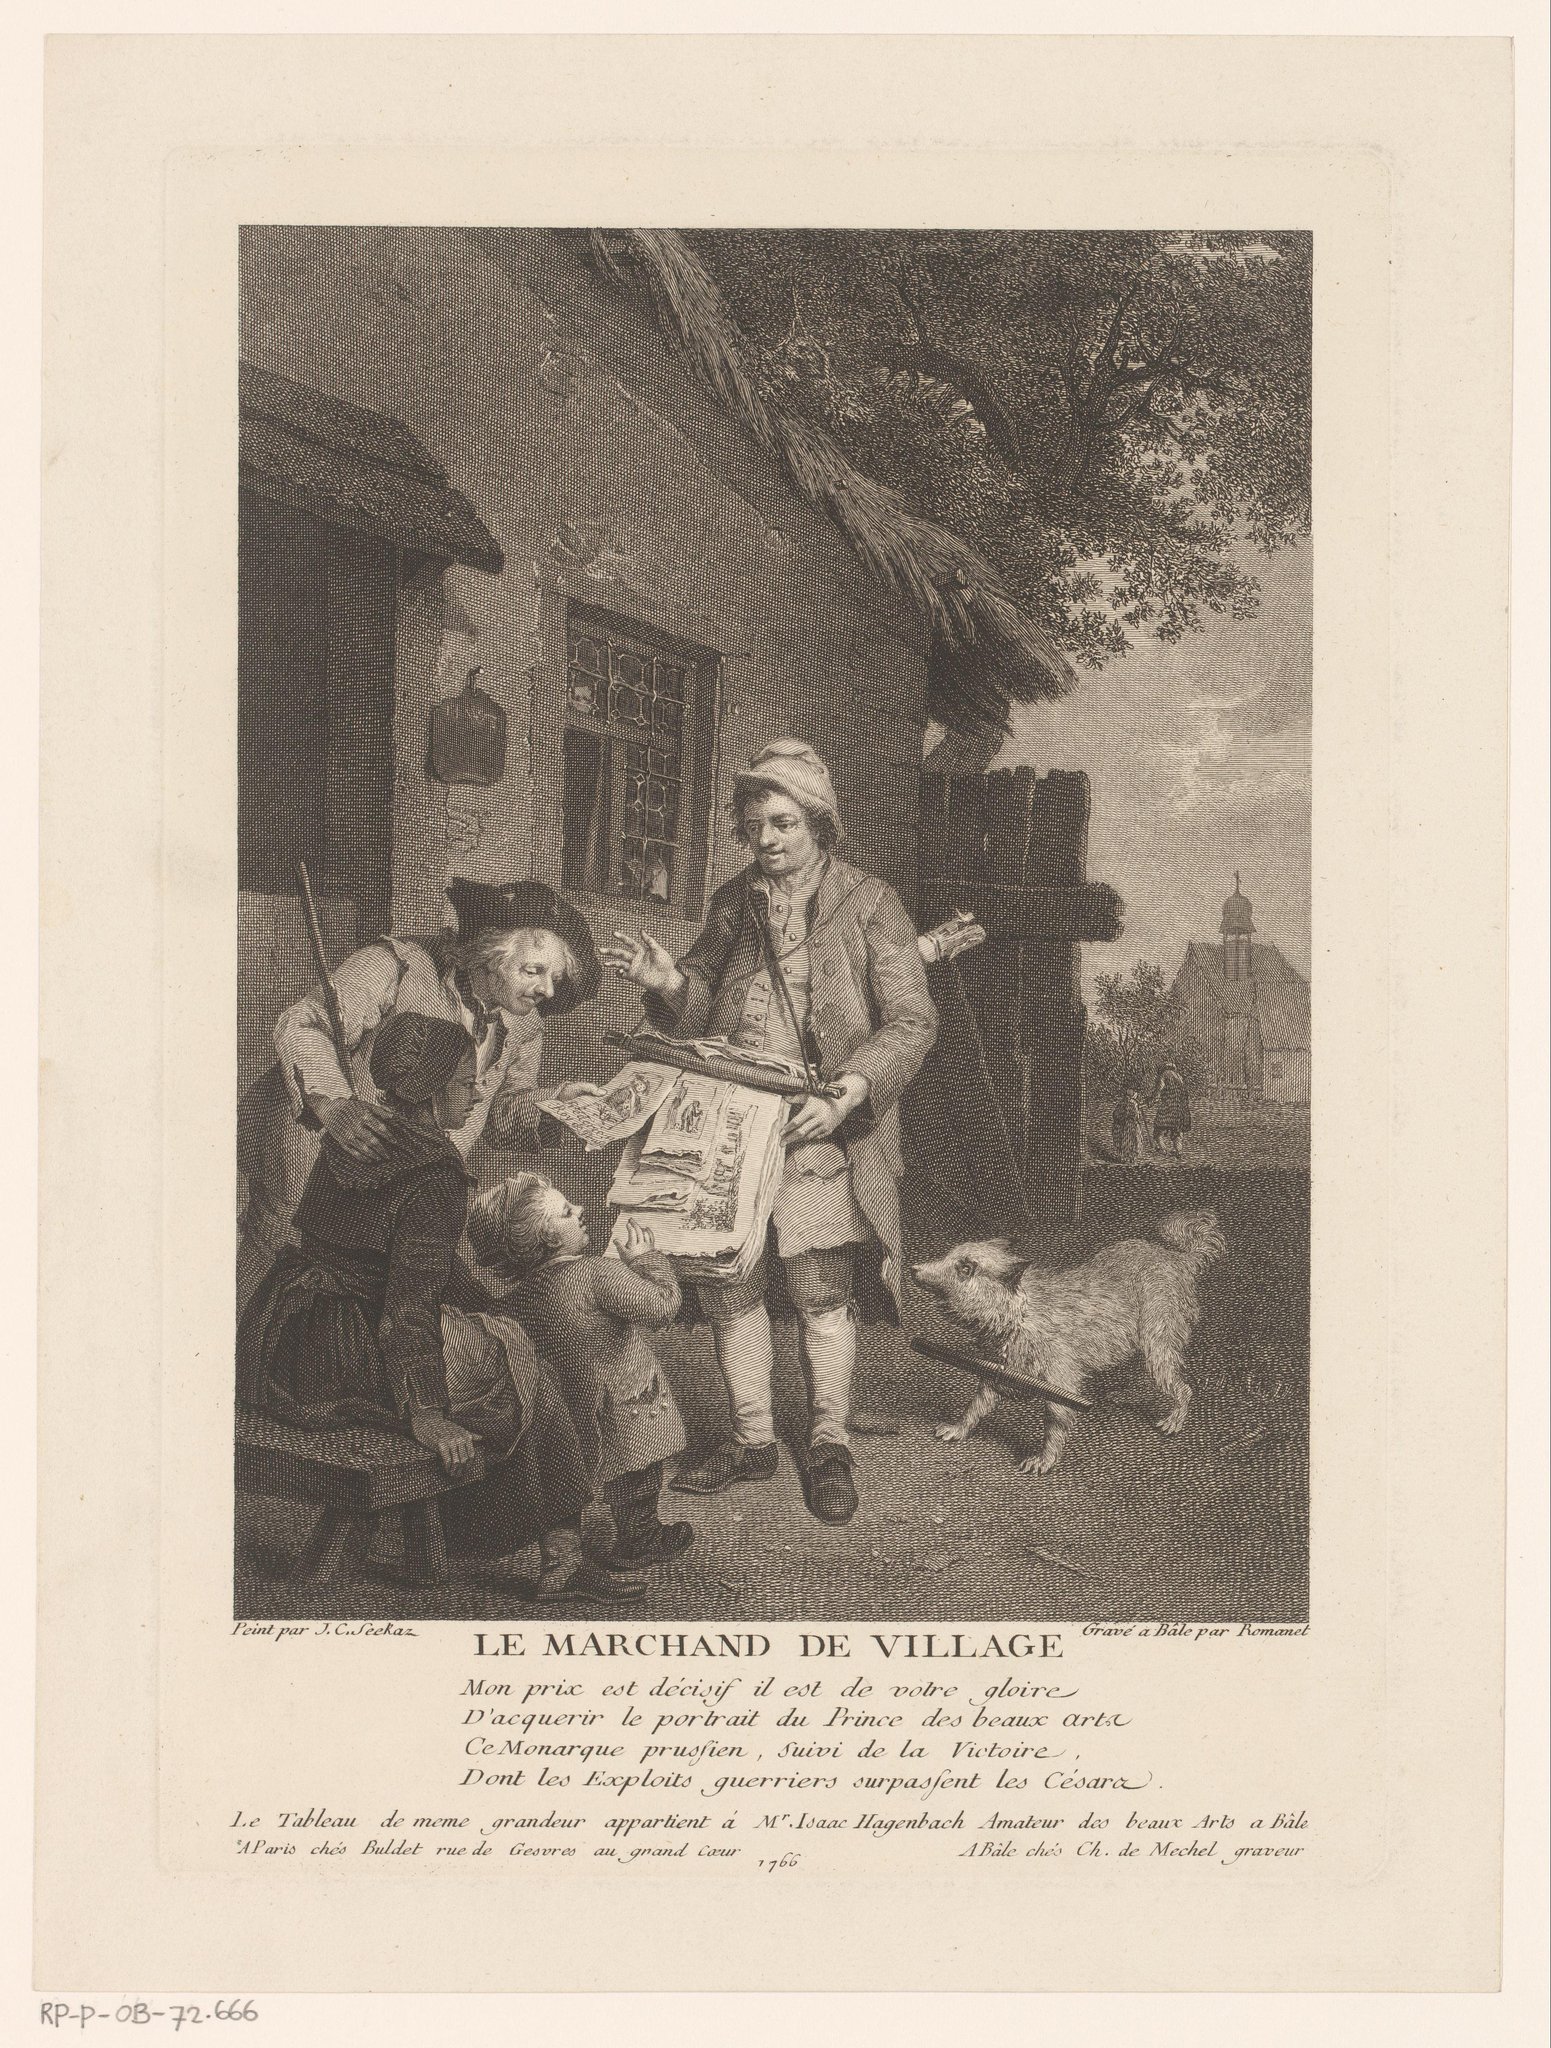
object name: print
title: Le Marchand de Village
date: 1766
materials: paper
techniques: engraving, etching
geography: basel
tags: print, e.g.: engraving, etching, lithograph, merchant, salesman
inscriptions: collector's mark: Lugt 2228